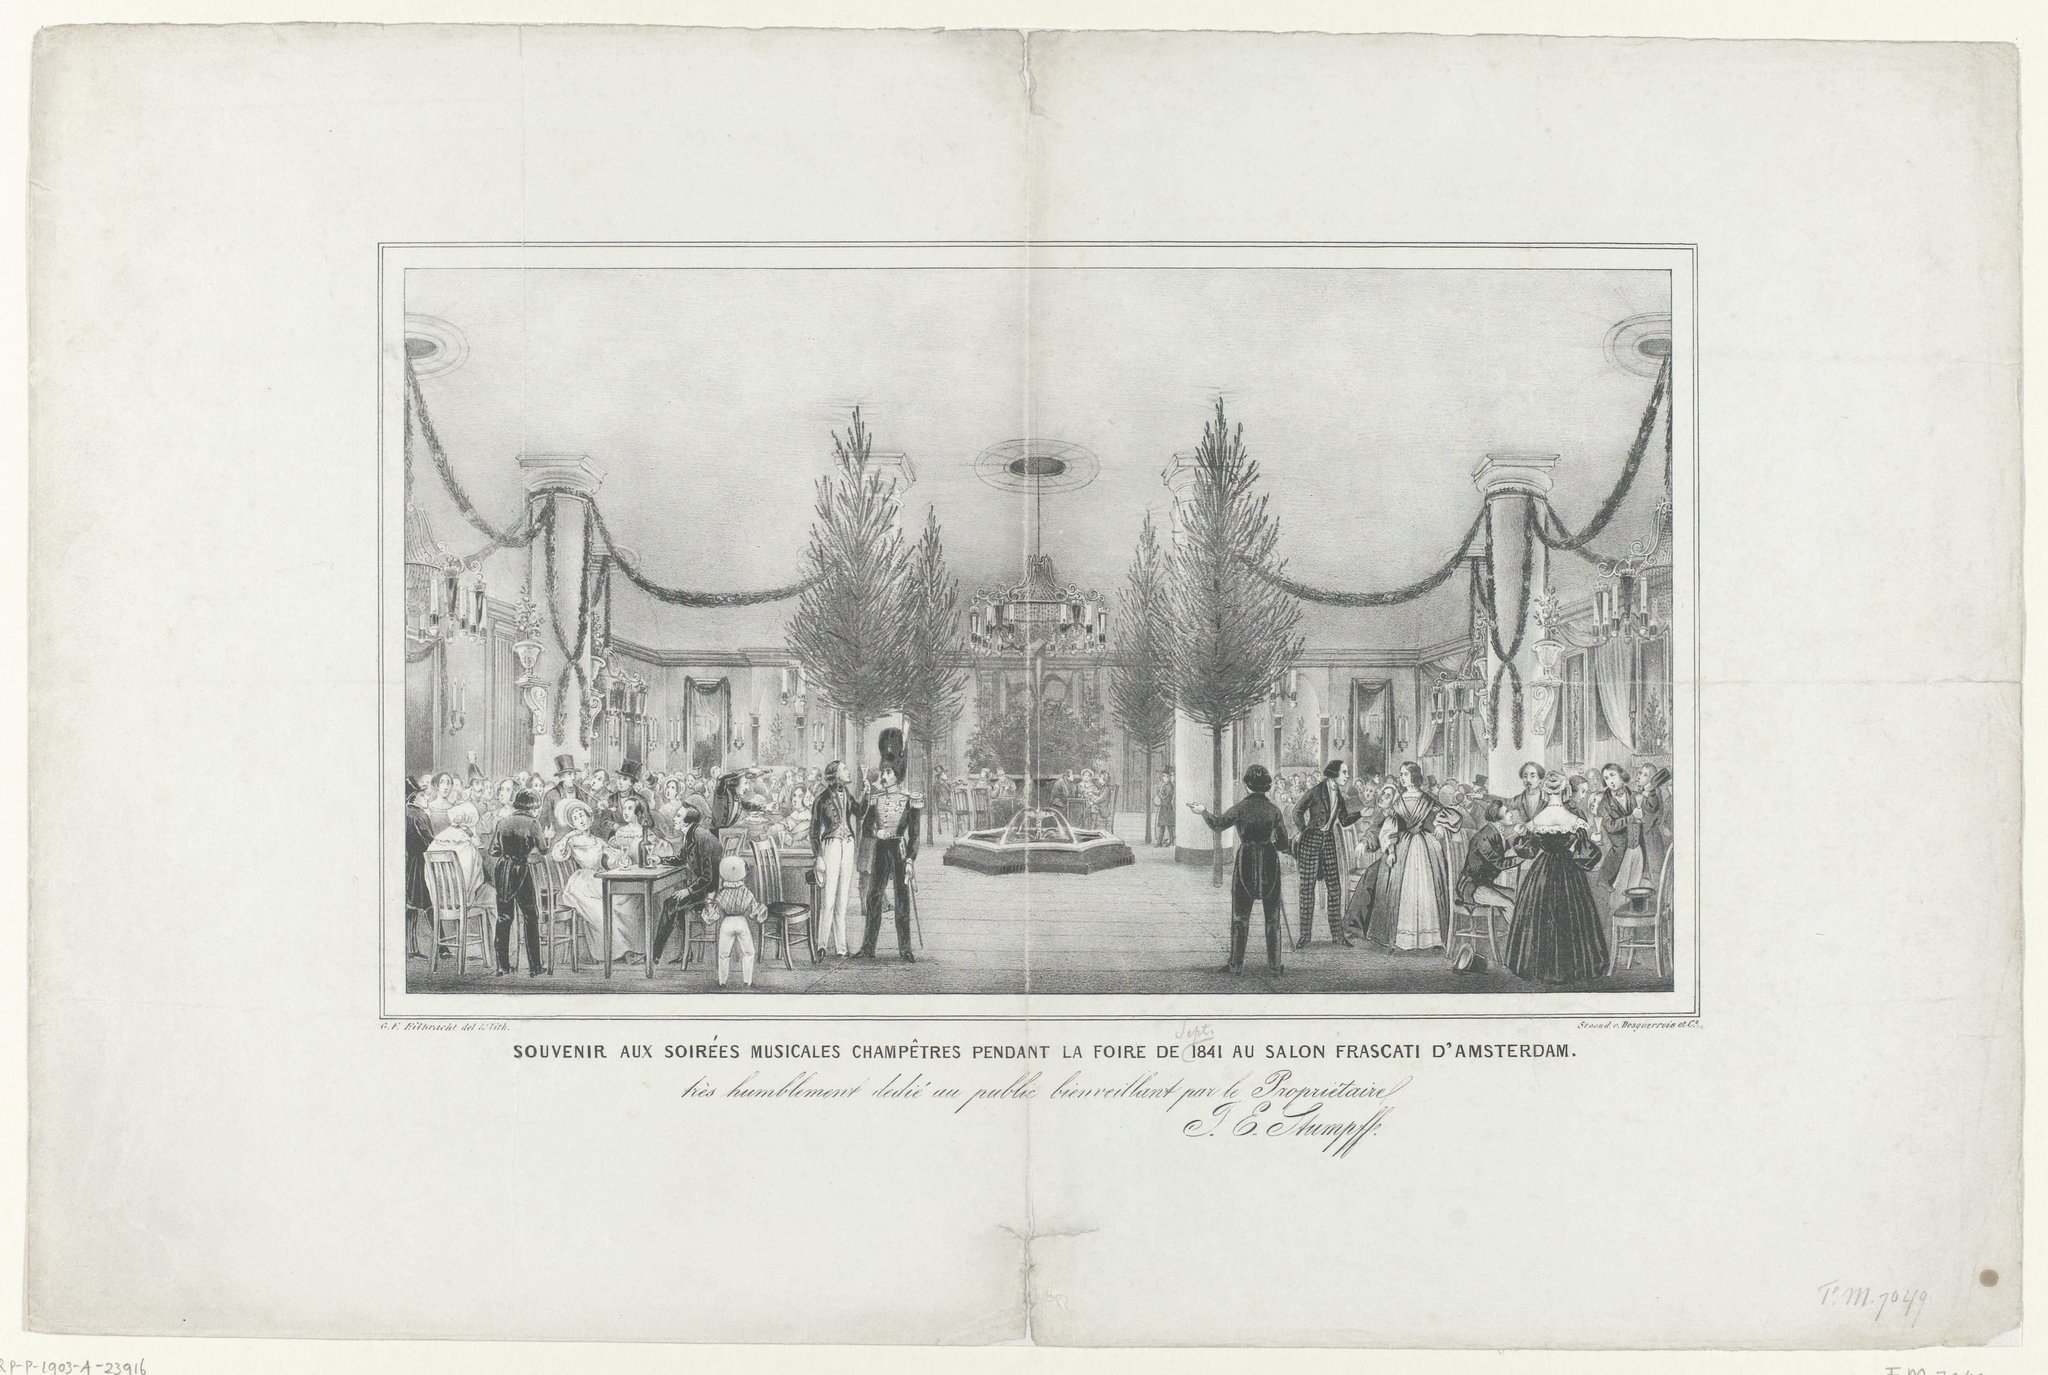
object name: print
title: Muzikale soiree in Frascati te Amsterdam, 1841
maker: gerhardus fredericus eilbracht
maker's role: draughtsman, print maker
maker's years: 1816-1854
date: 1841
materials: paper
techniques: lithograph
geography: netherlands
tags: inn, coffee-house, public house, etc., public festivities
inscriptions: collector's mark: Lugt 2228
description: Muzikale soiree gehouden, tijdens de kermis van september 1841, in de salon van Frascati te Amsterdam. Groepen mensen zittend aan tafels, in het midden een fontein en enkele bomen. Opgedragen aan 'het goedwillende publiek' door de uitbater J.E. Strumpff.